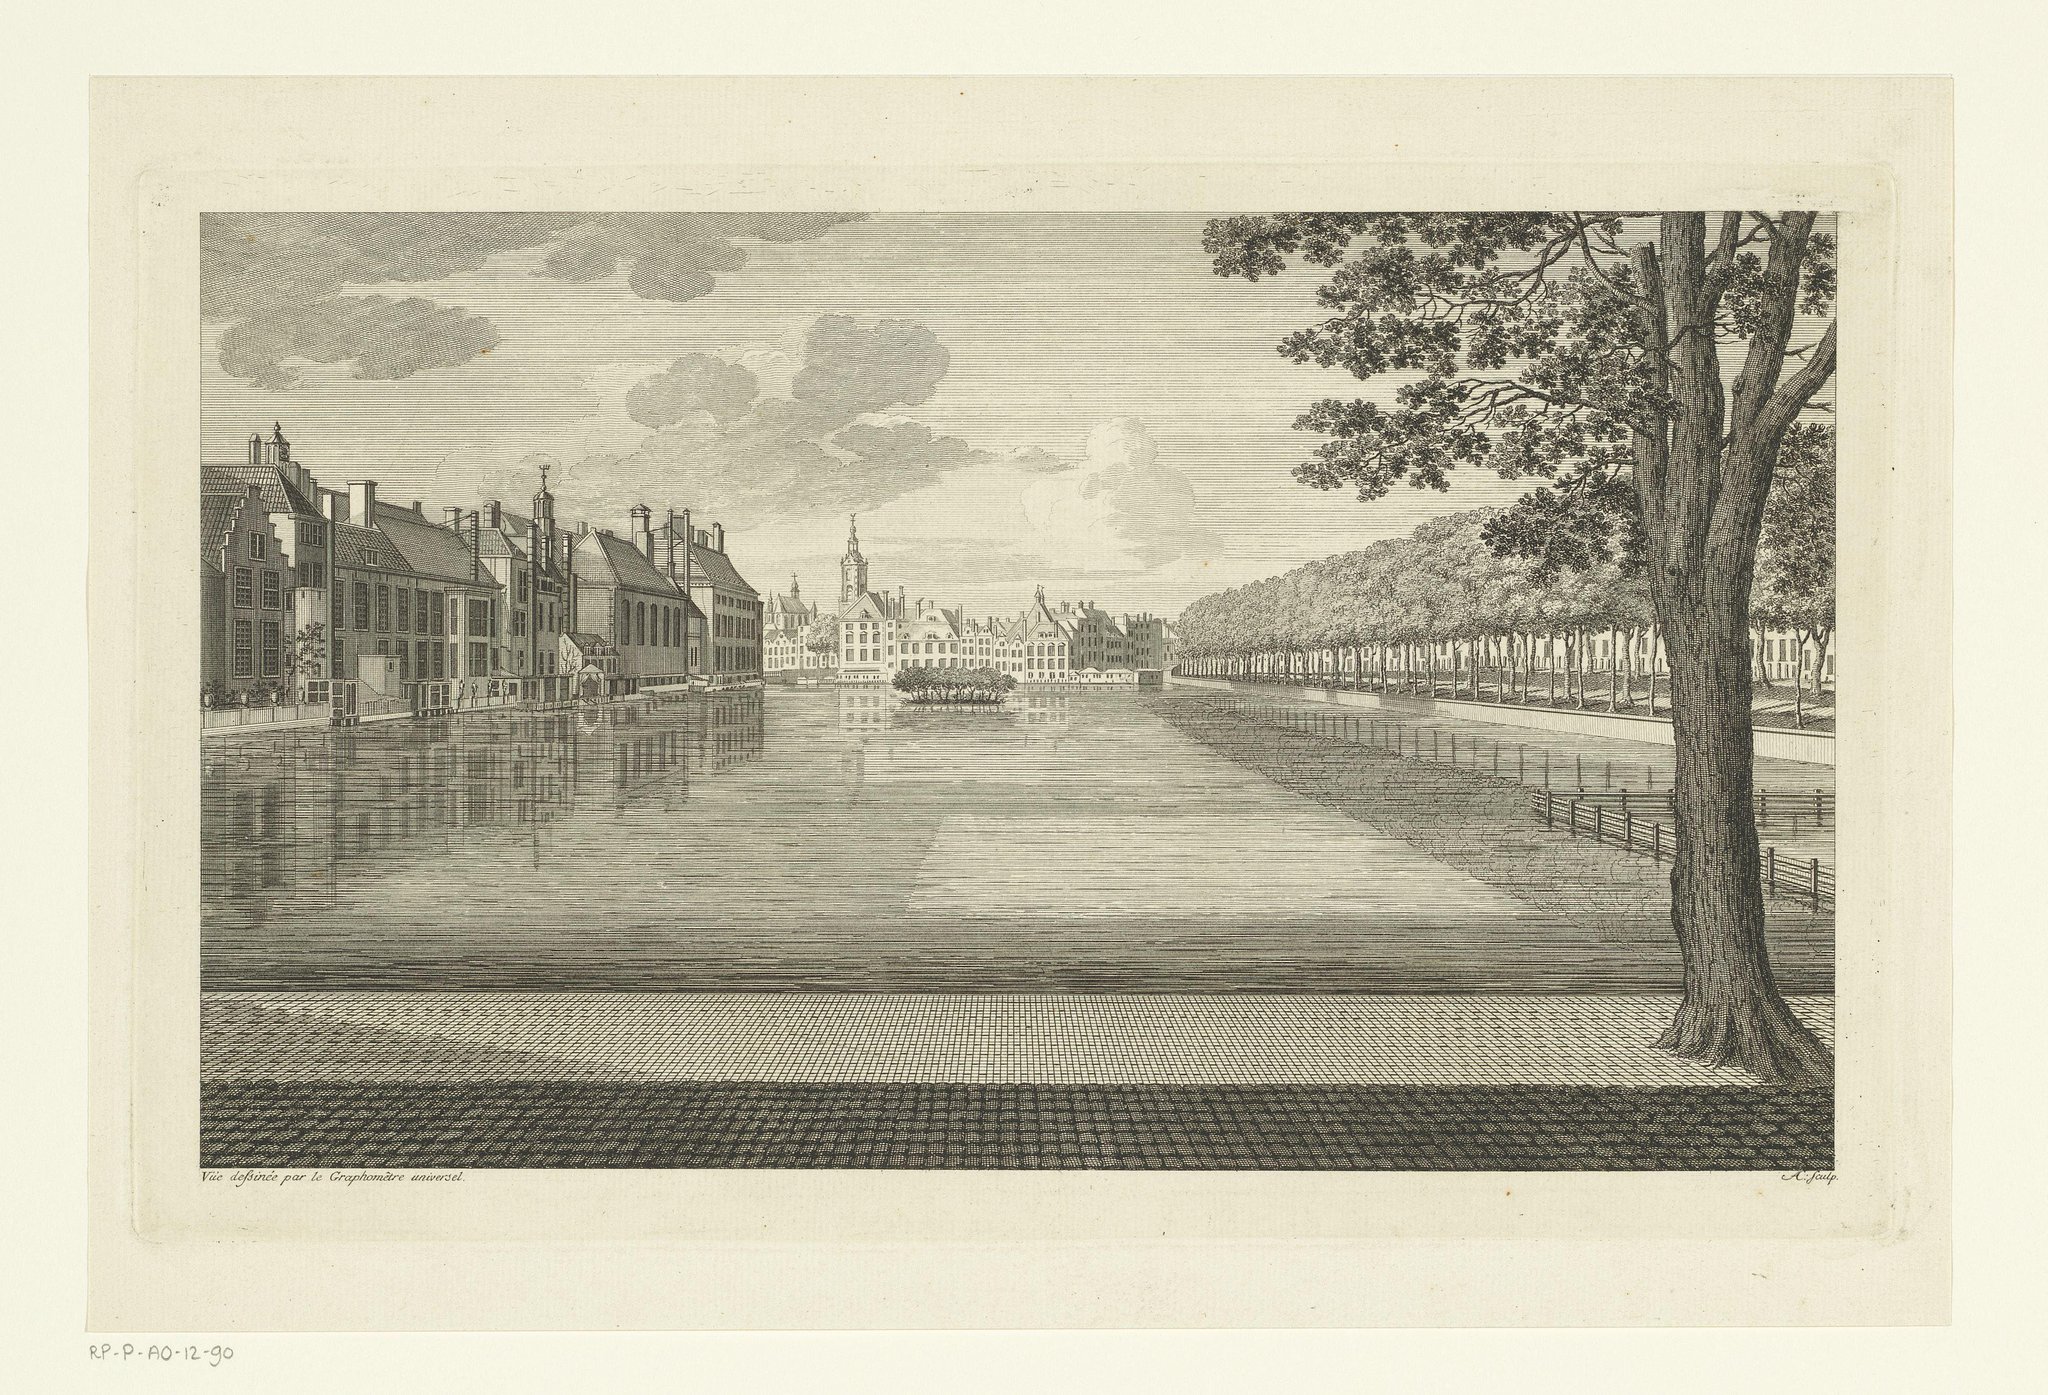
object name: print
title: Vuë dessinée par le graphomêtre universel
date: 1778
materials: paper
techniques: engraving, etching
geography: the hague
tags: city-view, and landscape with man-made constructions, pond, pool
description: Prent ook gebruikt in: Eckhardt, Antoine George. Description d'un graphometre universel, nouvel instrument, propre à dessiner toutes sortes d'objets de la maniere la plus exacte (...). Den Haag: Jan Hendrik Munnikhuizen, 1778. En in de Nederlandstalige uitgave: Eckhardt, Antoine George. Beschryving van een algemeenen graphometer, zynde een allernaauwkeurigst teken-werktuig (…). S.n.: Den Haag, 1778.